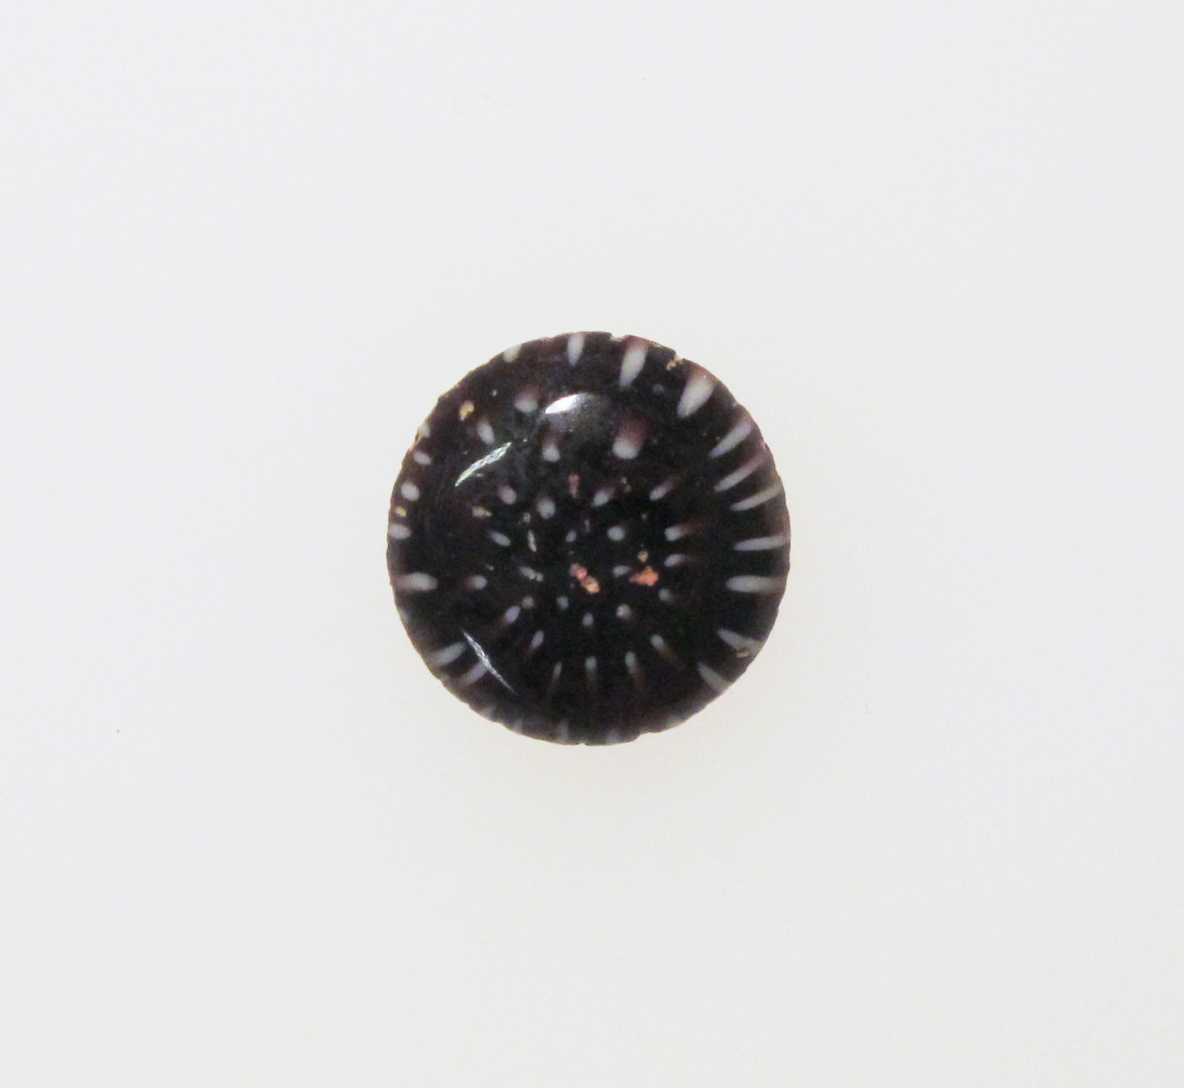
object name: millefiori pinhead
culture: roman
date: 670 BCE-330 CE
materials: gemstone, glass